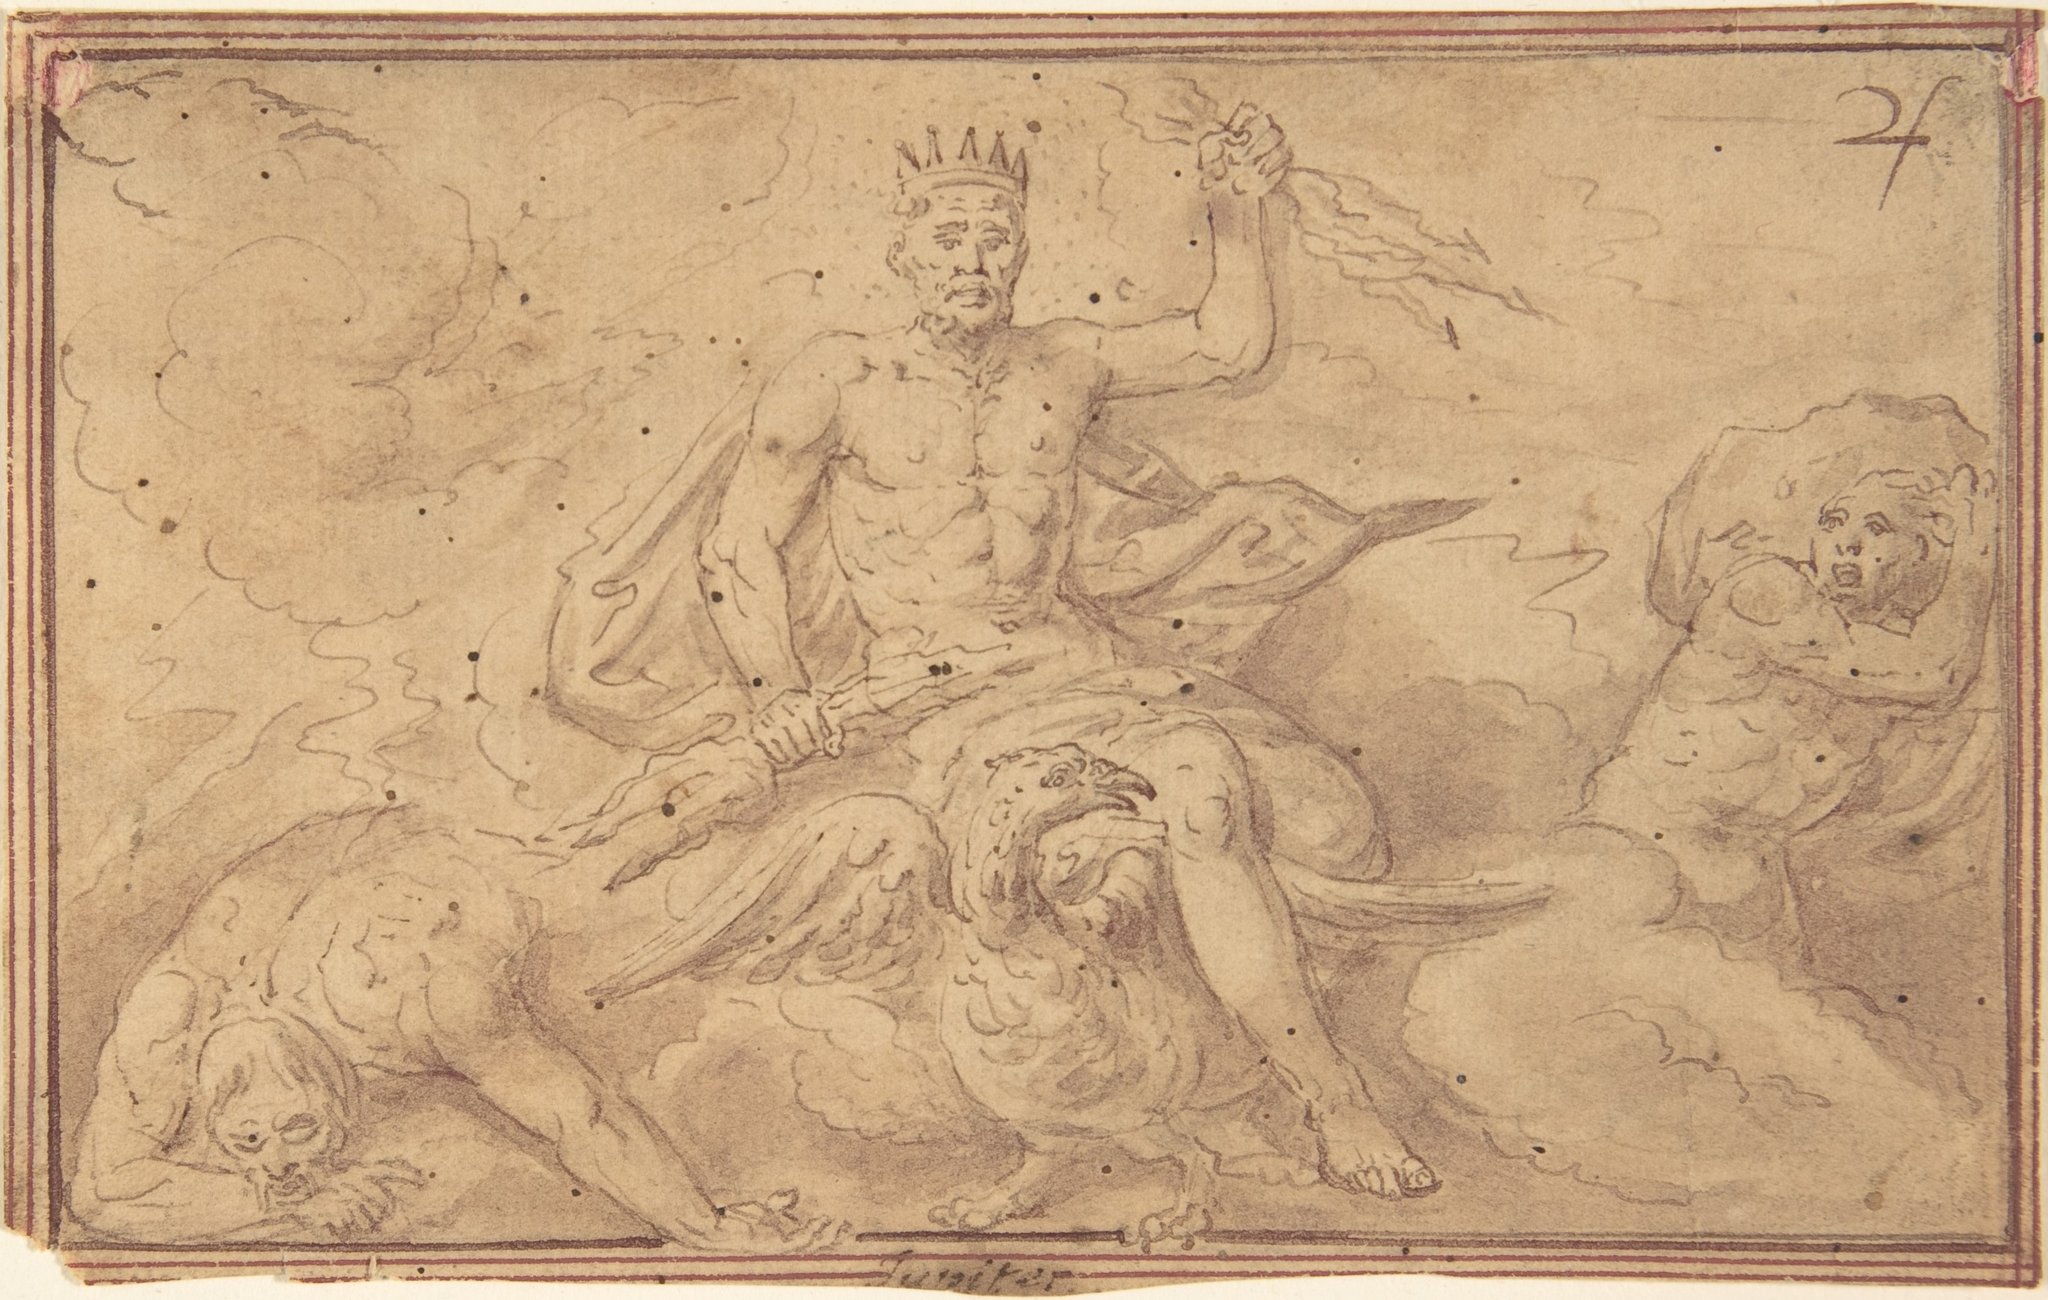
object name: drawing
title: Drawings of the Zodiac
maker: anonymous, netherlandish, 16th century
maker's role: artist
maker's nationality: netherlandish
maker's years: 1500-1600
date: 1501-1600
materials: ink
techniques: brush, pen, wash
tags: birds,men,zodiac